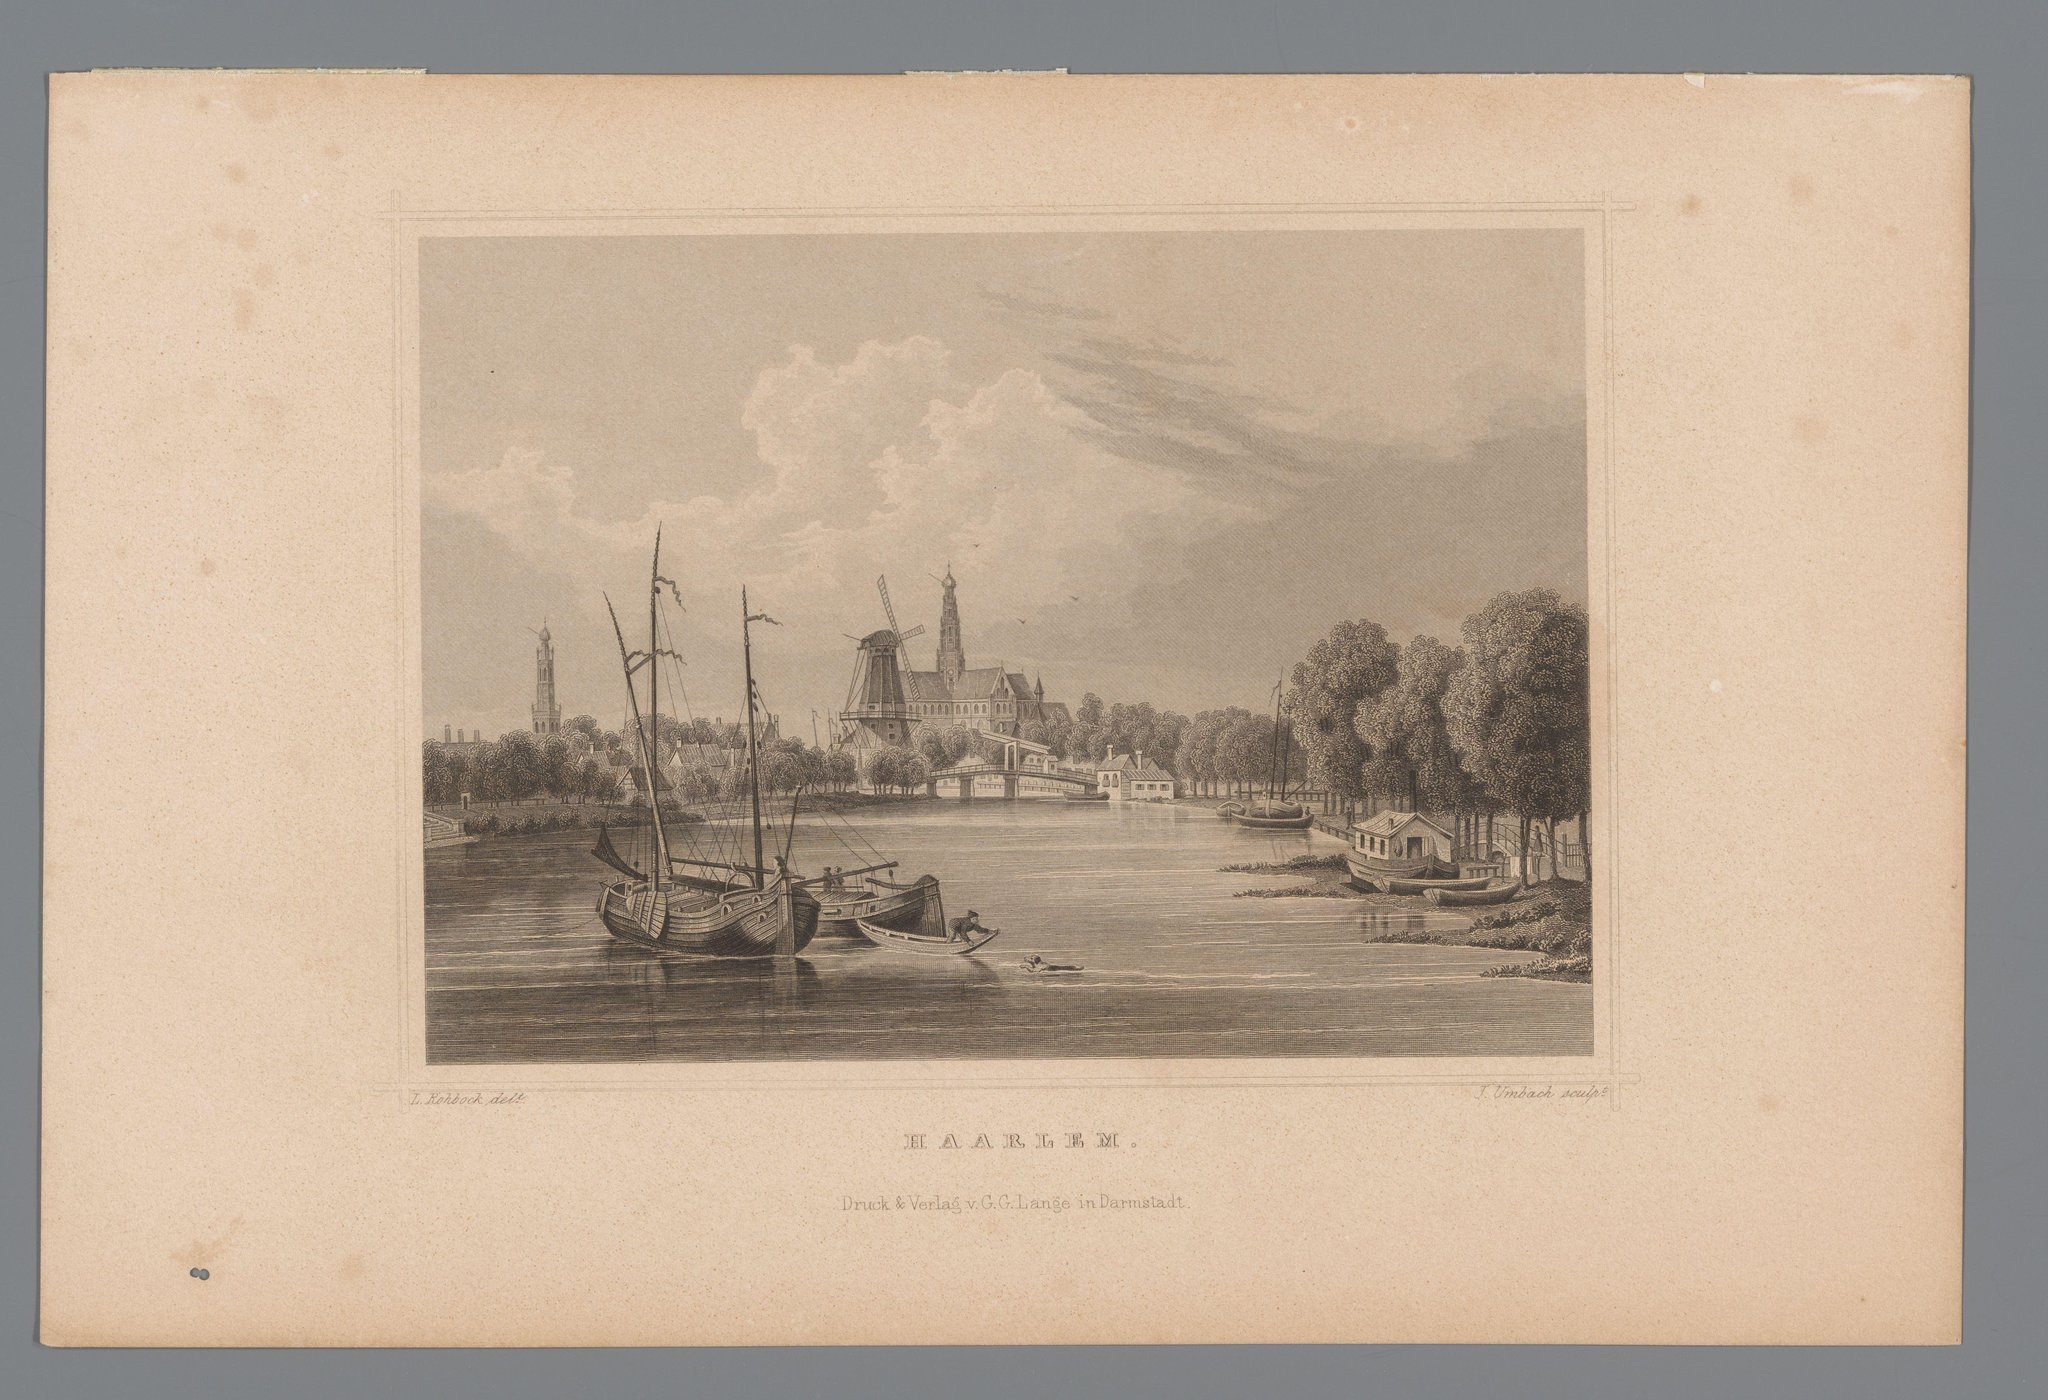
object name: book illustration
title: Gezicht op Haarlem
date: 1863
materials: paper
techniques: engraving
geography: darmstadt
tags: sailing-ship, sailing-boat, city-view in general; 'veduta', river, haarlem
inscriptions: collector's mark: Lugt 2233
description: Prent uit: Der Rhein und die Rheinlande in malerischen Original-ansichten. 3 dln. Darmstadt: G.G. Lange, 1863, dl. 3, p. 362-363. Dezelfde prent, met een ander onderschrift, komt ook voor in: Terwen, J.L. Het koningrijk der Nederlanden (...). 2 dln. Gouda, G.B. van Goor, 1855.